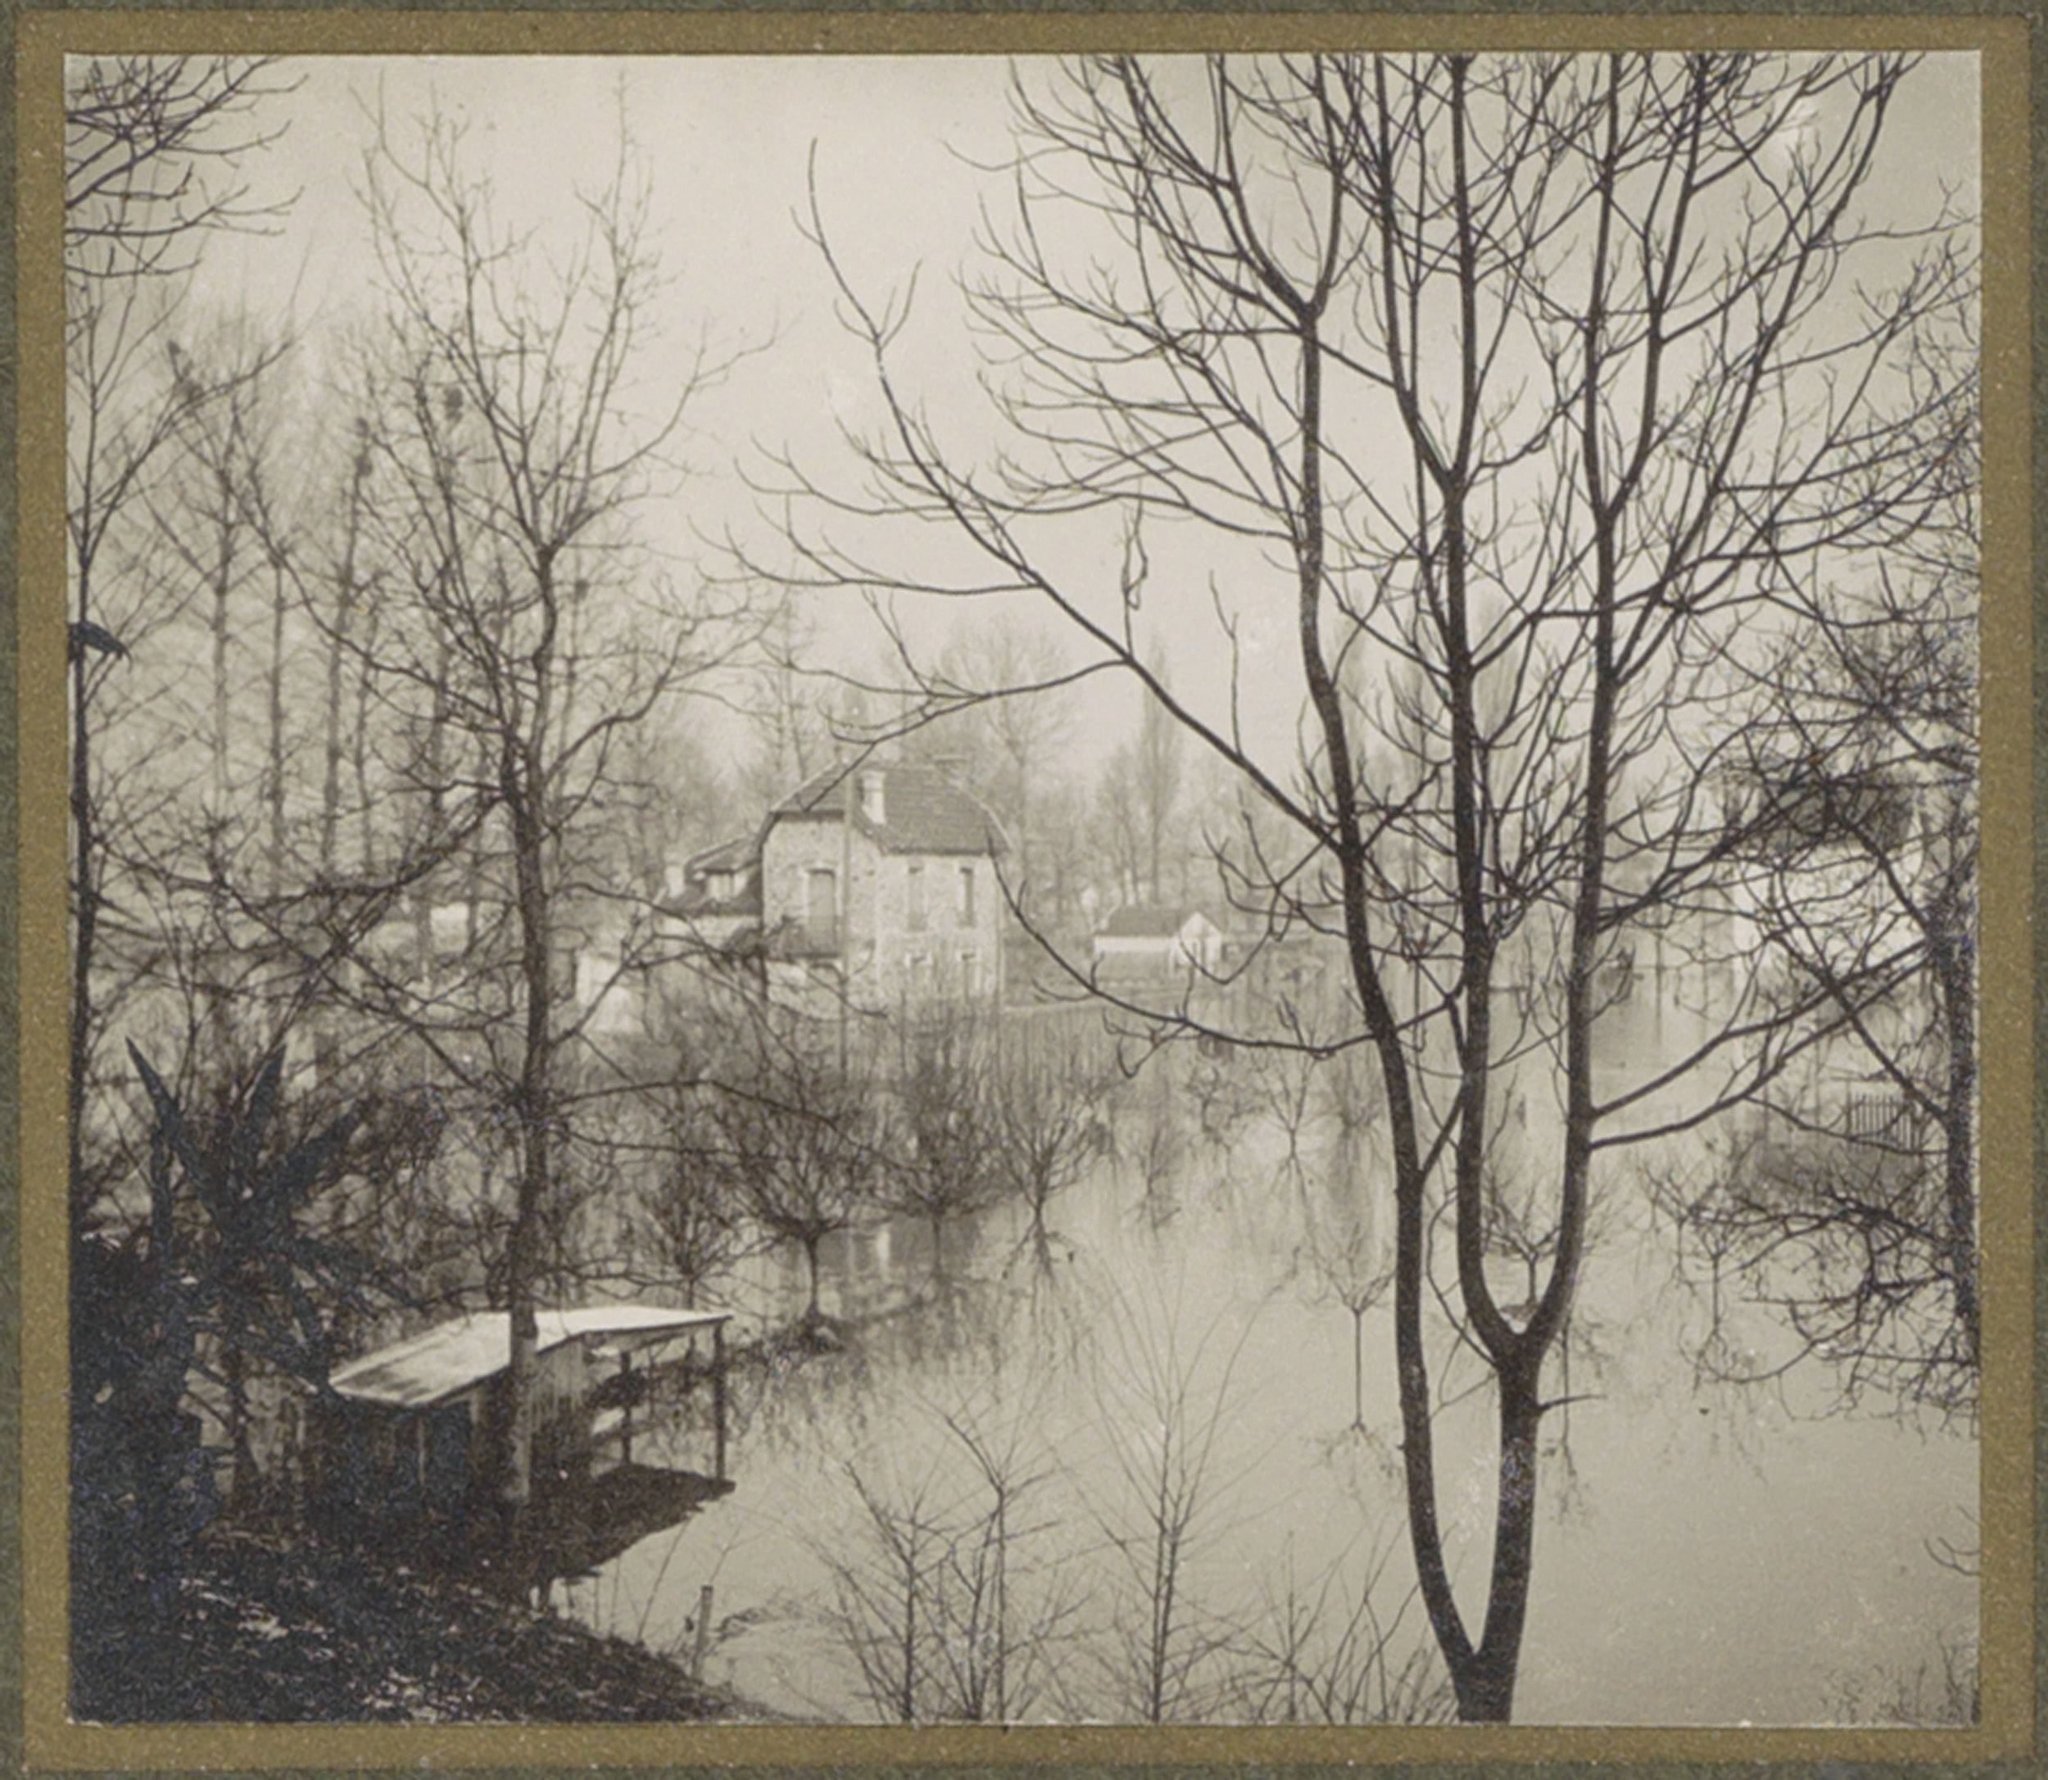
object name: photograph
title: Huis in ondergelopen buitenwijk van Parijs gezien door kale bomen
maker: g. dangereux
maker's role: fotograaf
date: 1901-1910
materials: photographic support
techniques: matte daylight collodion silver print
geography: paris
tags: flood (+ landscape with figures, staffage), paris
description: Onderdeel van fotoalbum overstroming Parijs en voorsteden 1910.